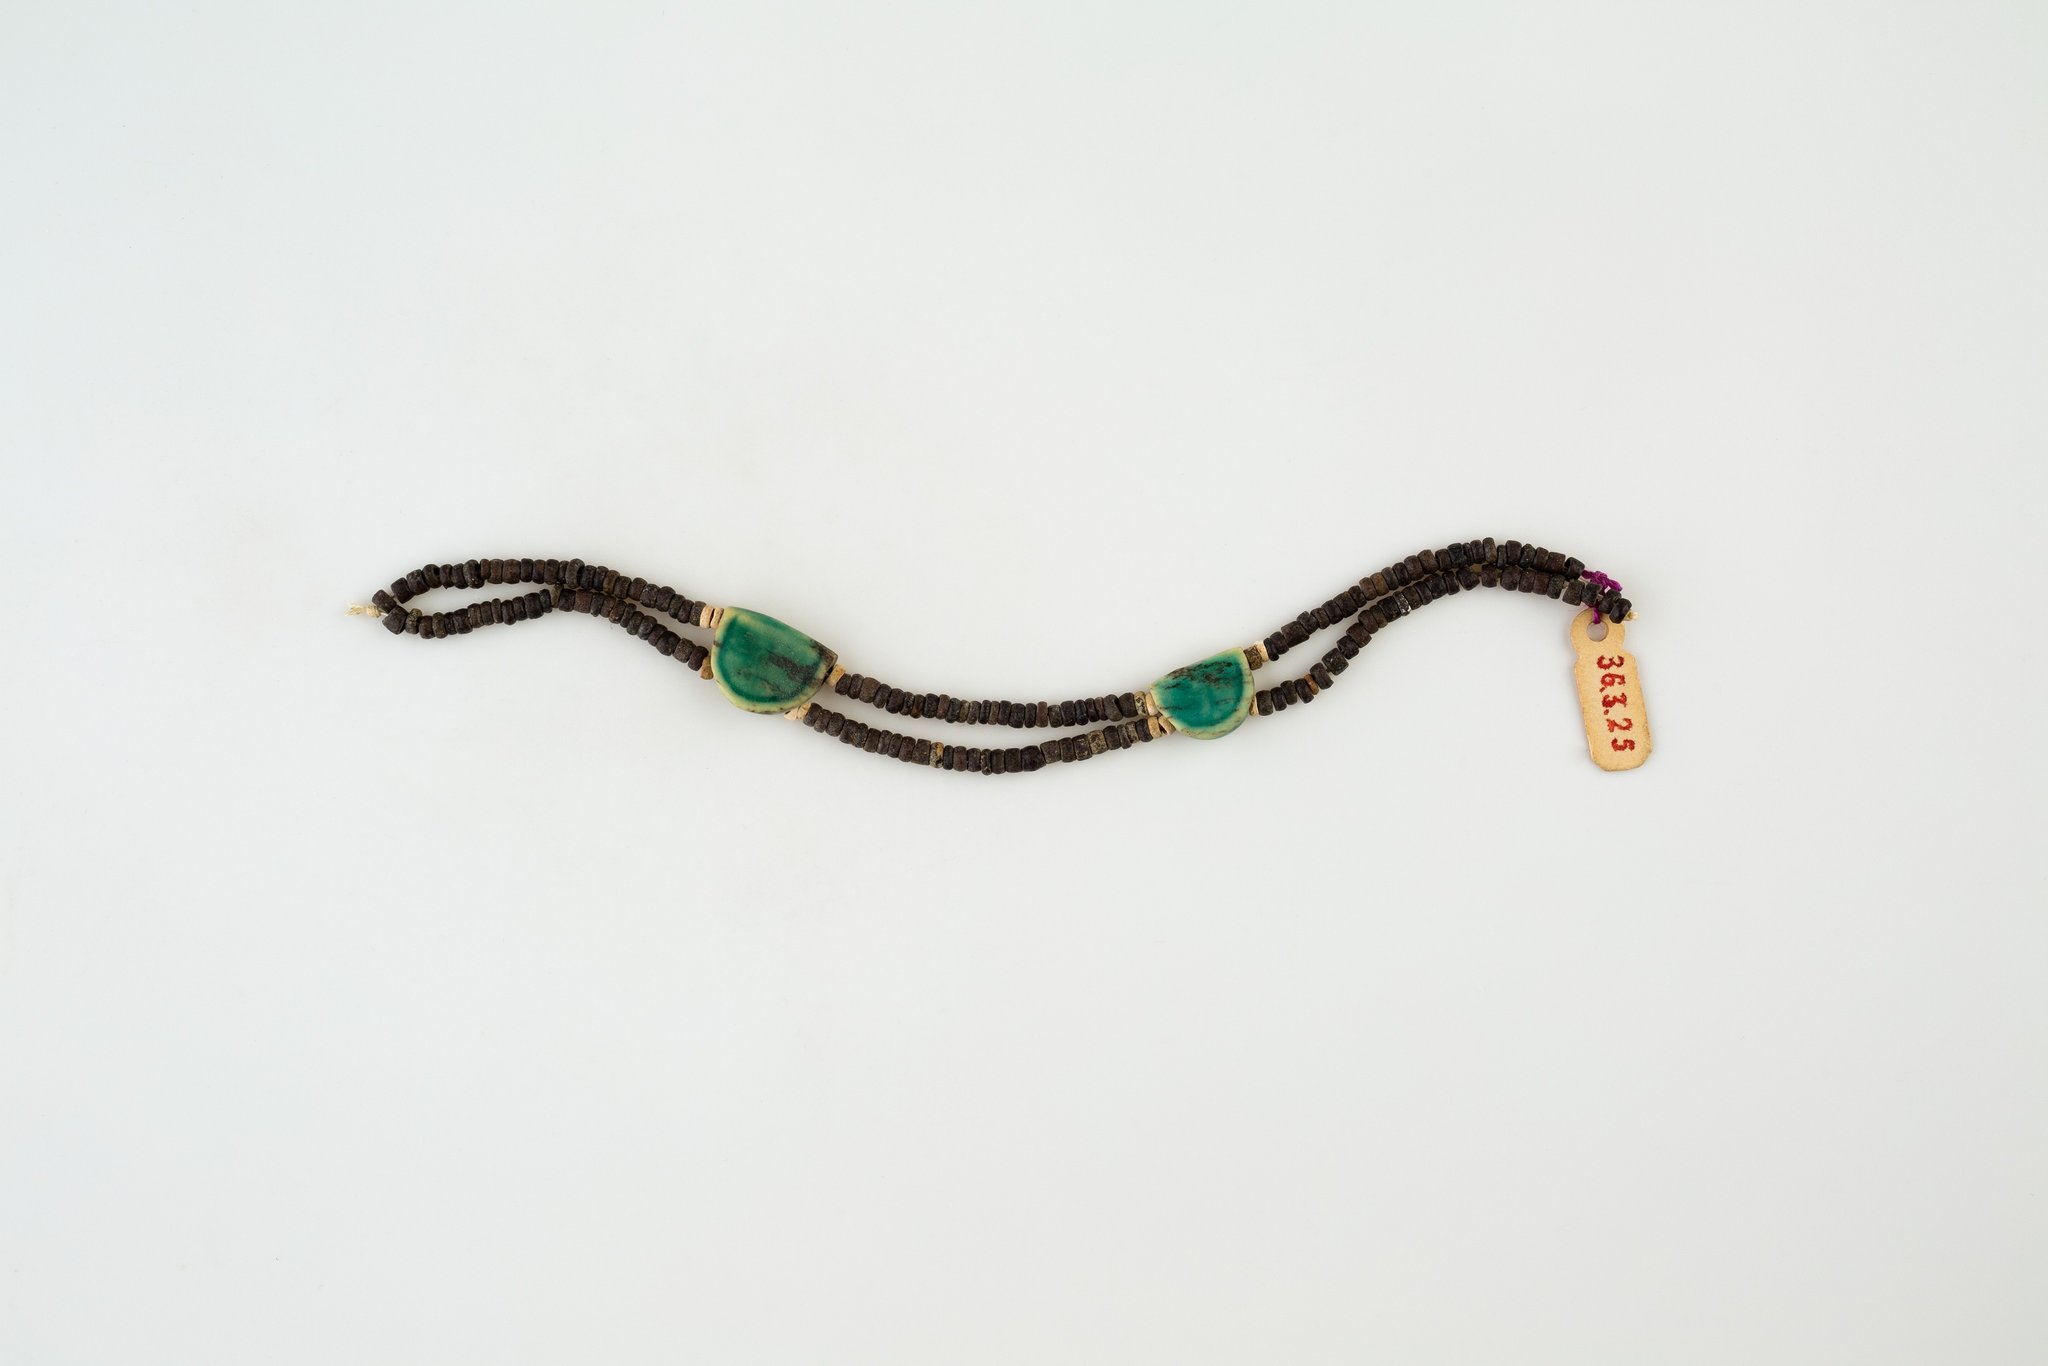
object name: bracelet, bead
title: Bracelet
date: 1492-1473 BCE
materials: faience, stone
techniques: glazing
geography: egypt